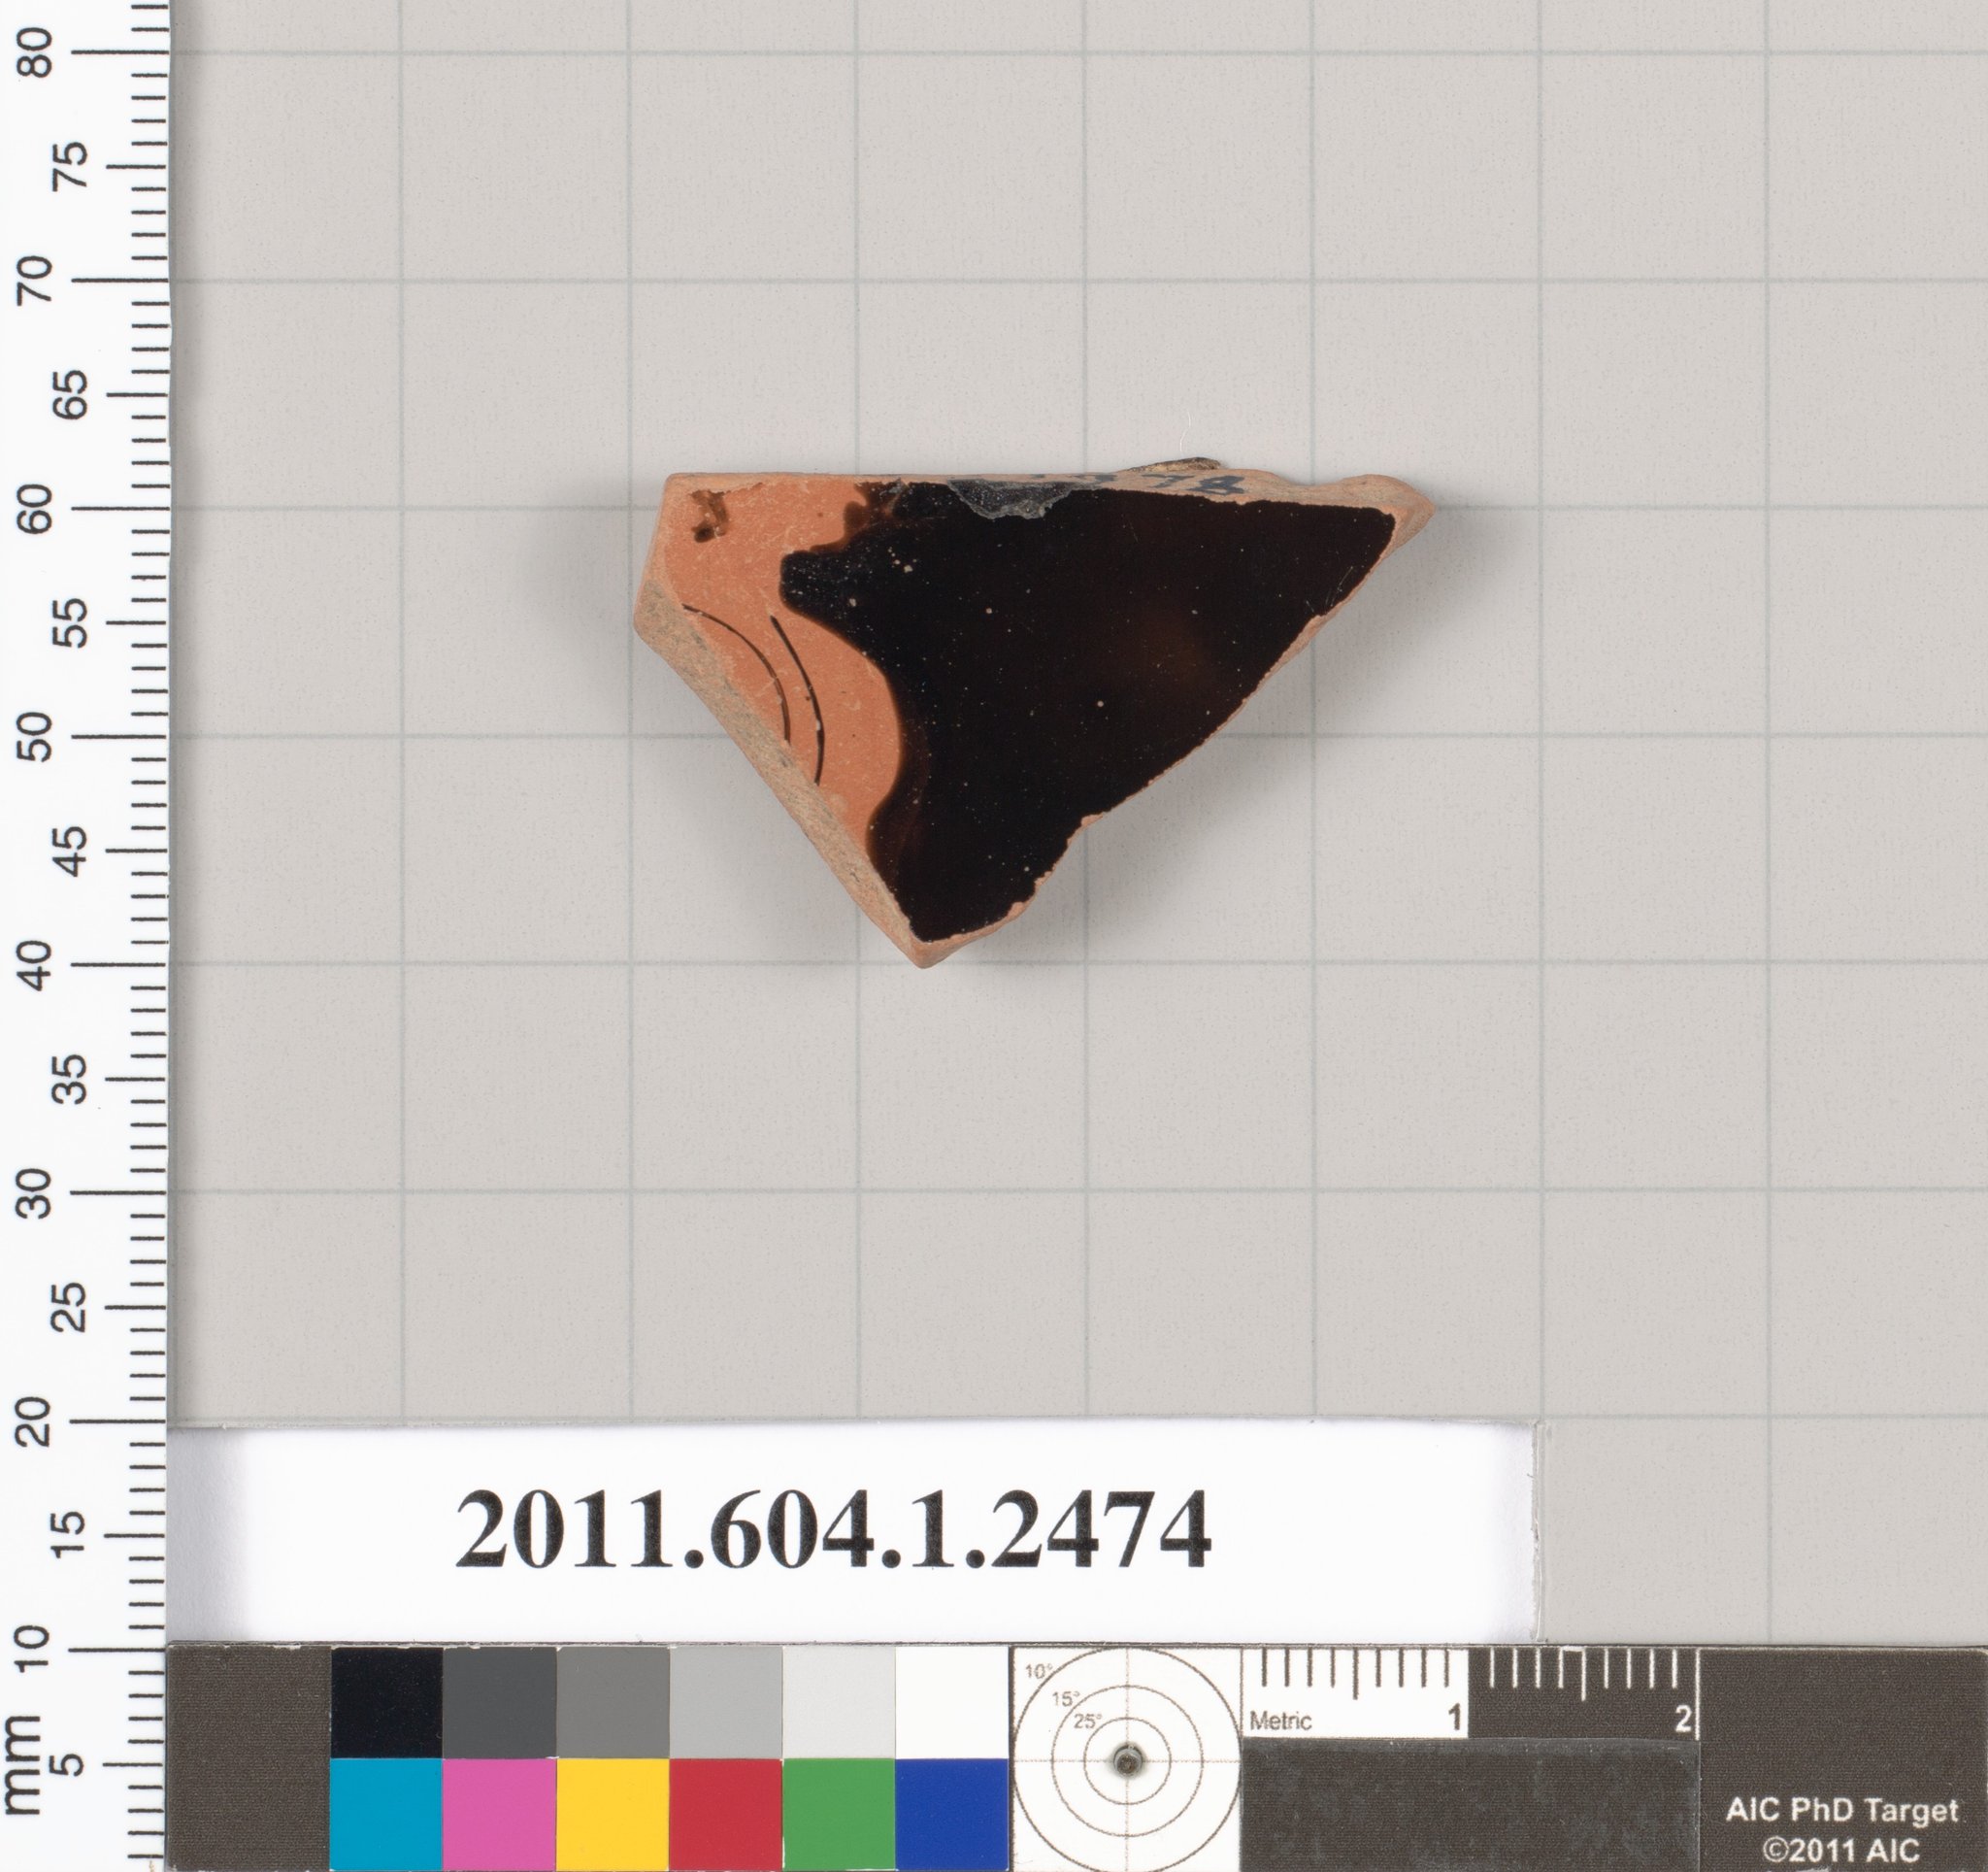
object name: kylix fragment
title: Terracotta fragment of a kylix (drinking cup)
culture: greek, attic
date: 475-451 BCE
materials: terracotta